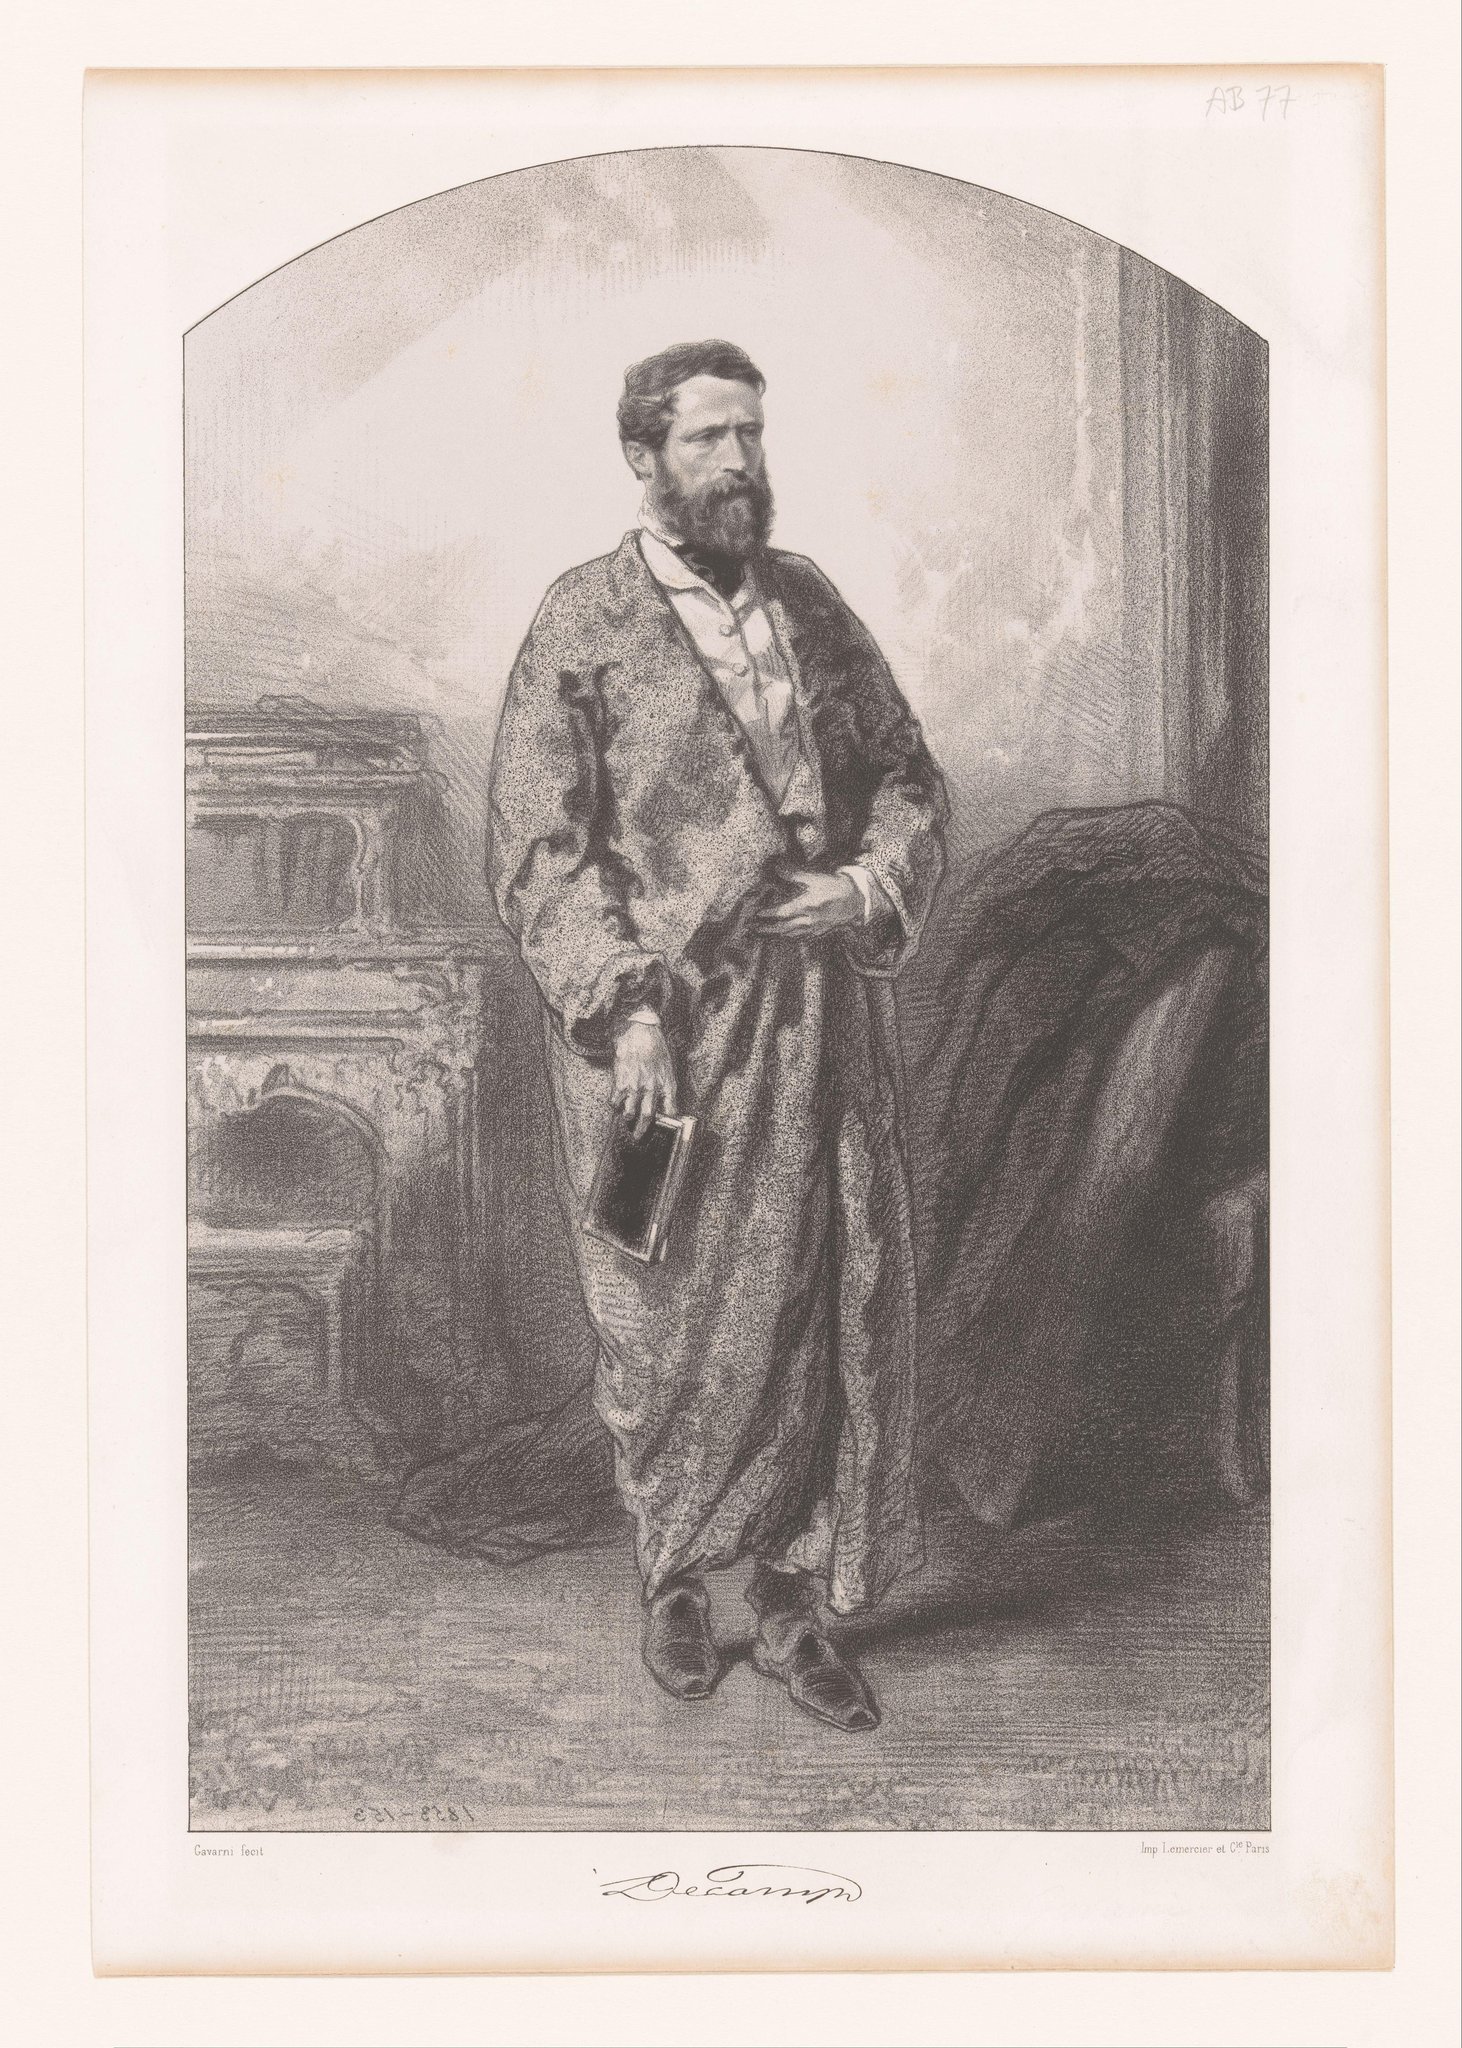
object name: print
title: Portret van Alexandre-Gabriel Decamps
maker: paul gavarni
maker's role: draughtsman, print maker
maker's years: 1804-1866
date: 1853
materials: paper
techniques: lithograph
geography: paris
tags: painter, print maker, draughtsman, alexandre-gabriel decamps, historical persons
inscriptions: collector's mark: Lugt 2228a, collector's mark: Lugt 2760